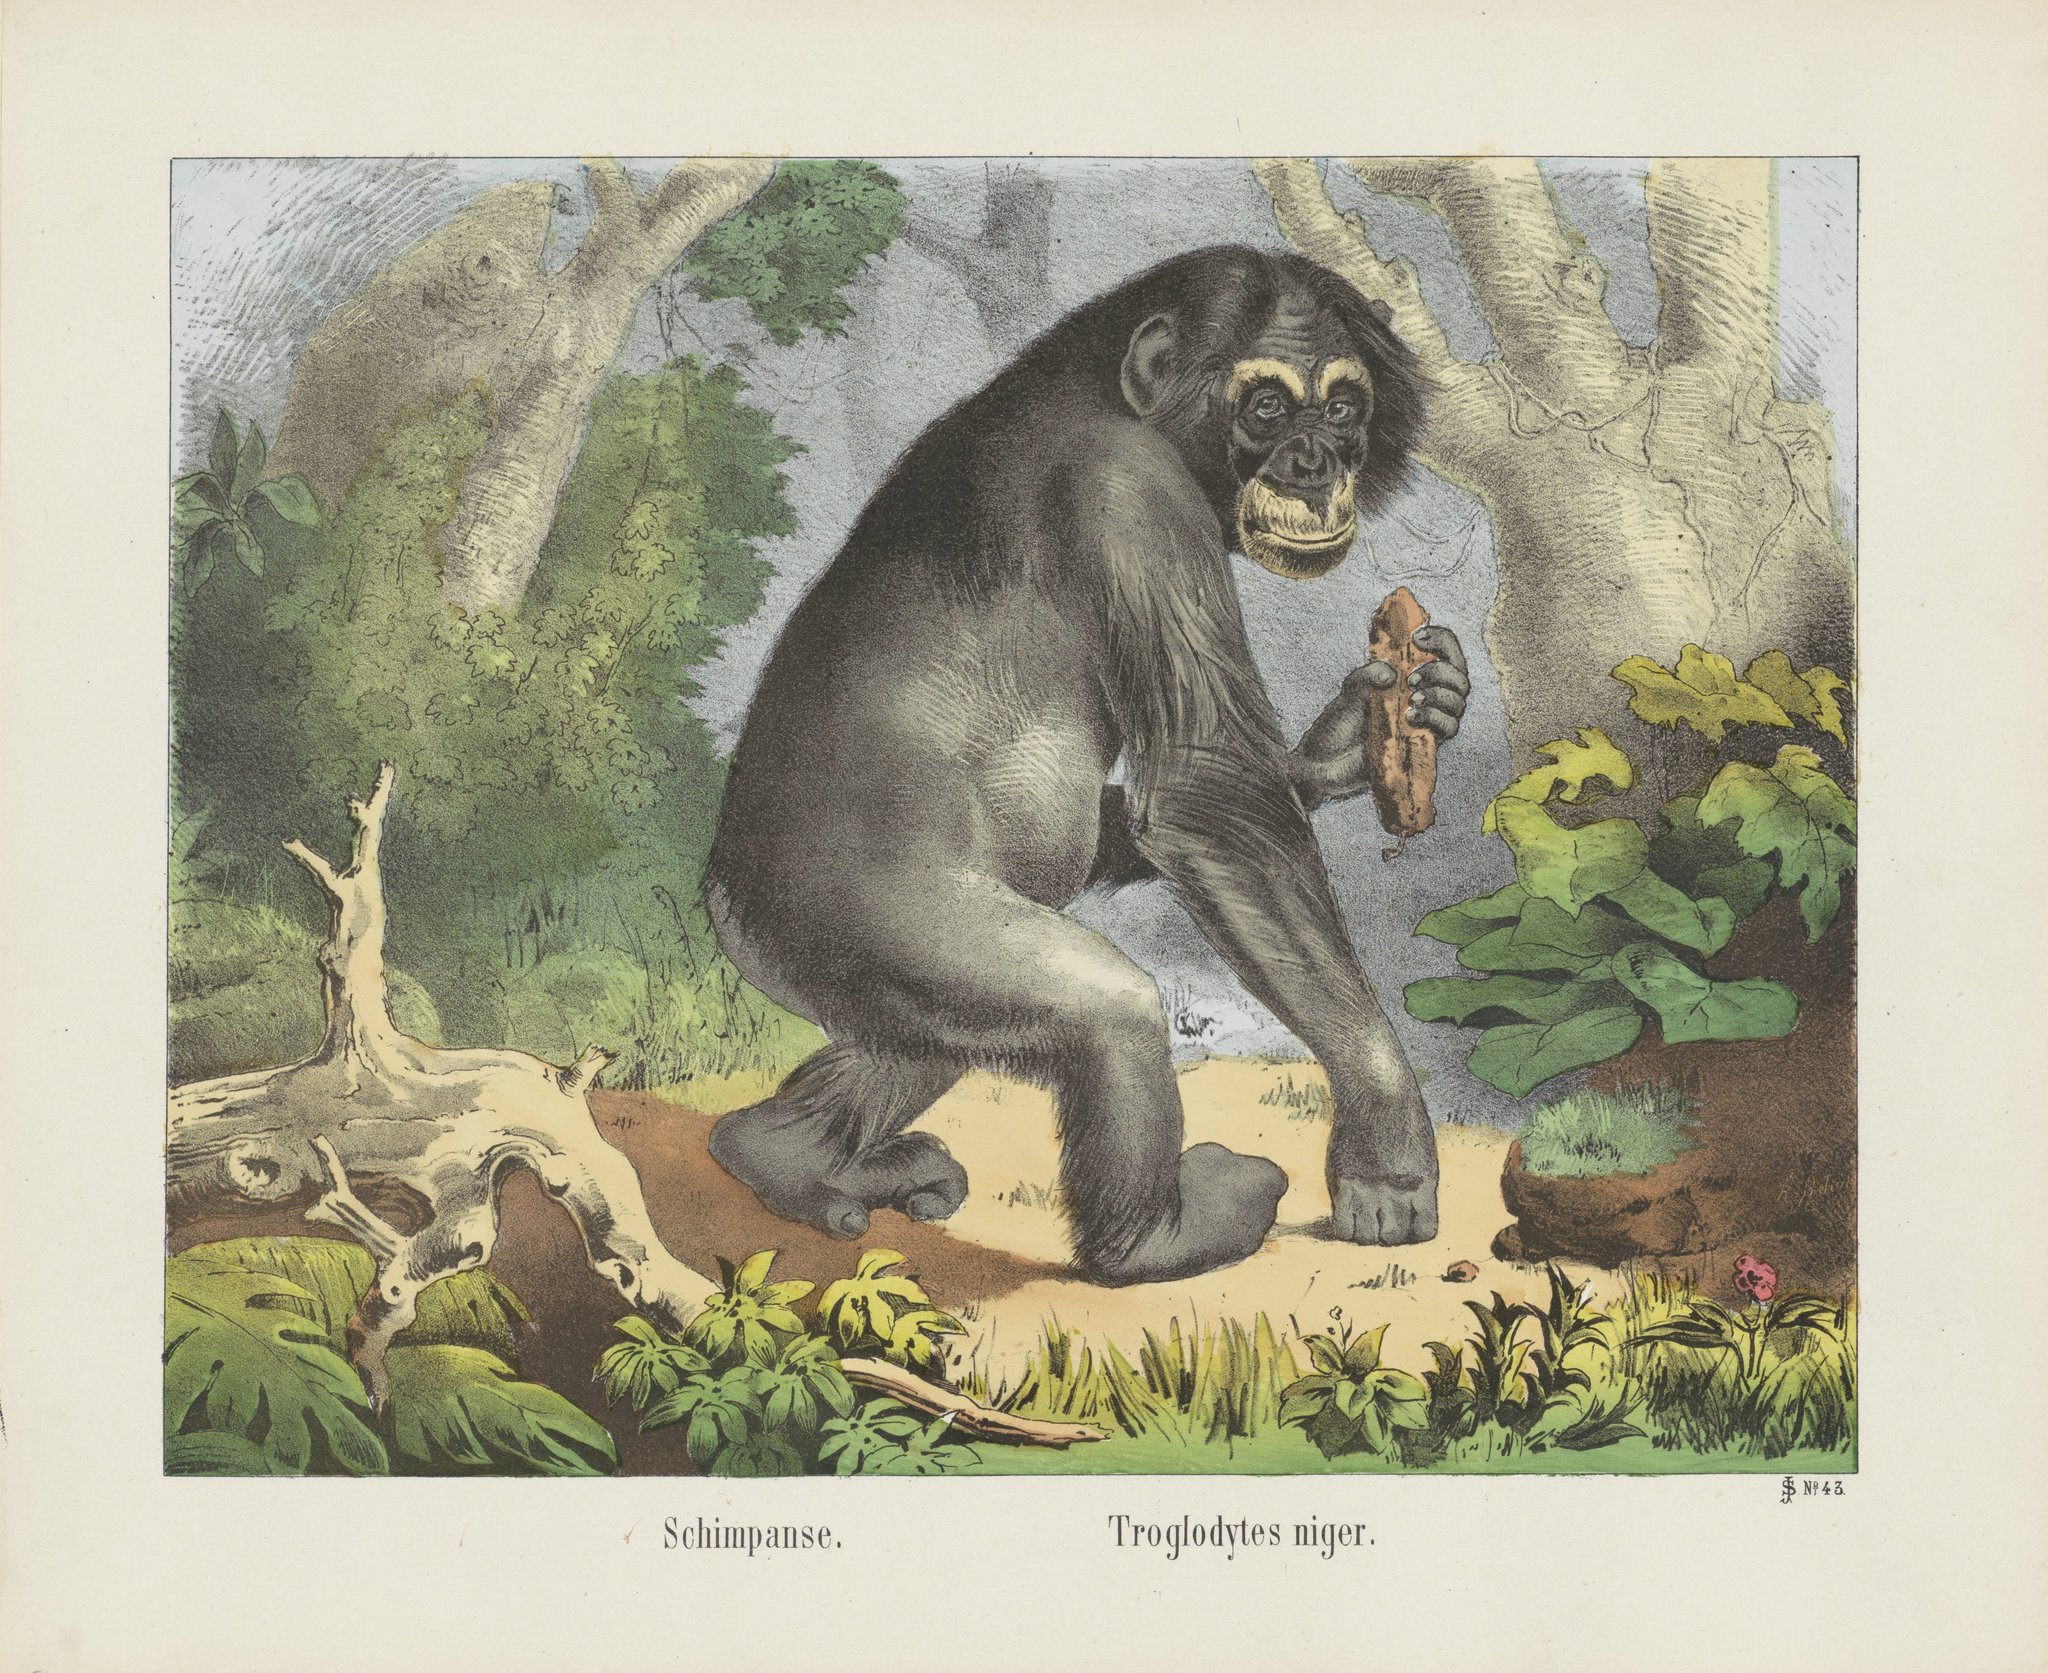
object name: popular print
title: Schimpanse. / Troglodytes niger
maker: Anonymous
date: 1829-1880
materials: paper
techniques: colour, letterpress printing, lithograph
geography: europe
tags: monkeys, apes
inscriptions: collector's mark: Lugt 2760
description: Chimpansee lopend door een oerwoud. Genummerd rechtsonder: No. 43.